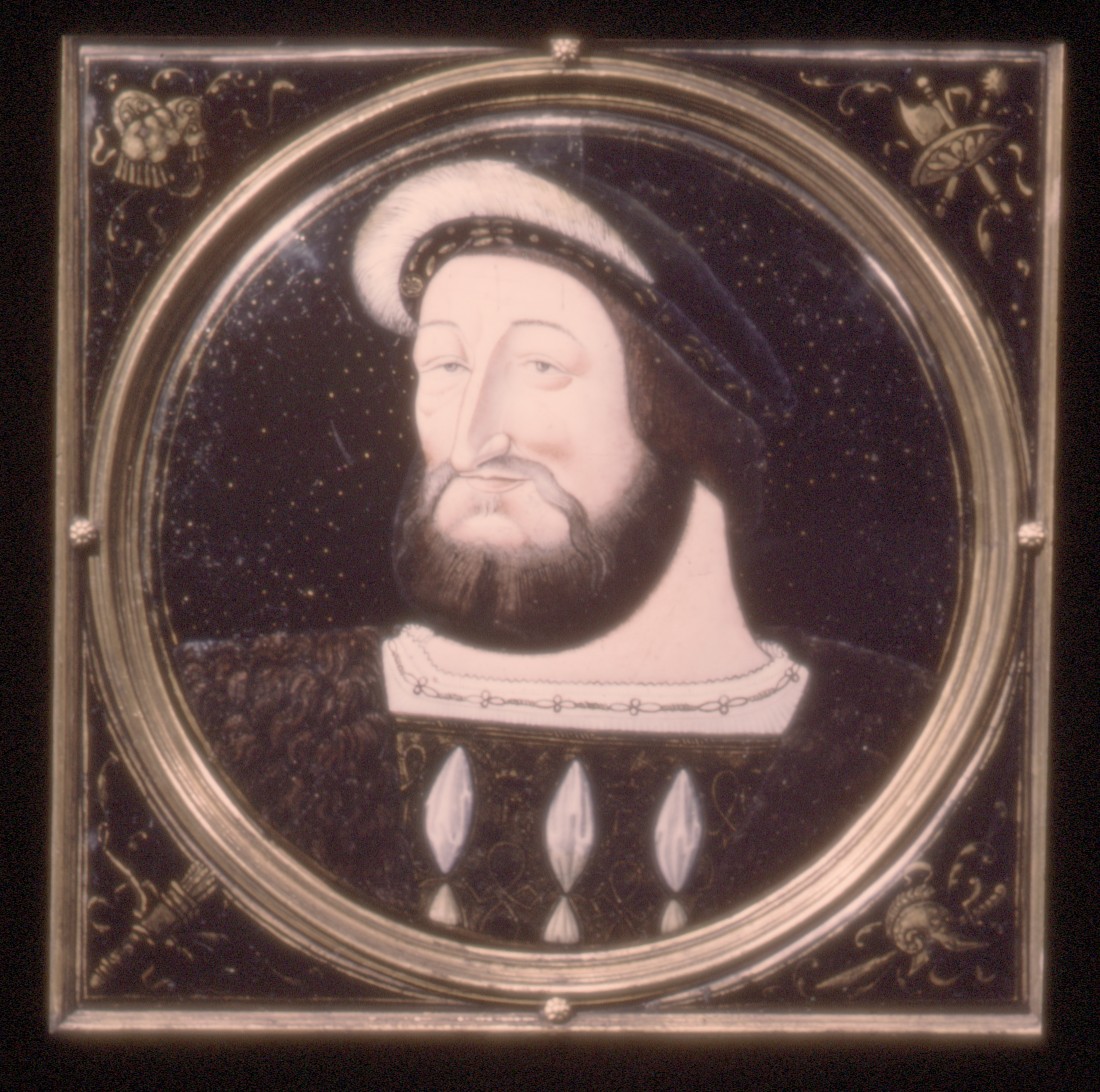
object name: plaque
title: François I, King of France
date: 1801-1900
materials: copper, enamel, gilt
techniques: painting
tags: kings,portraits